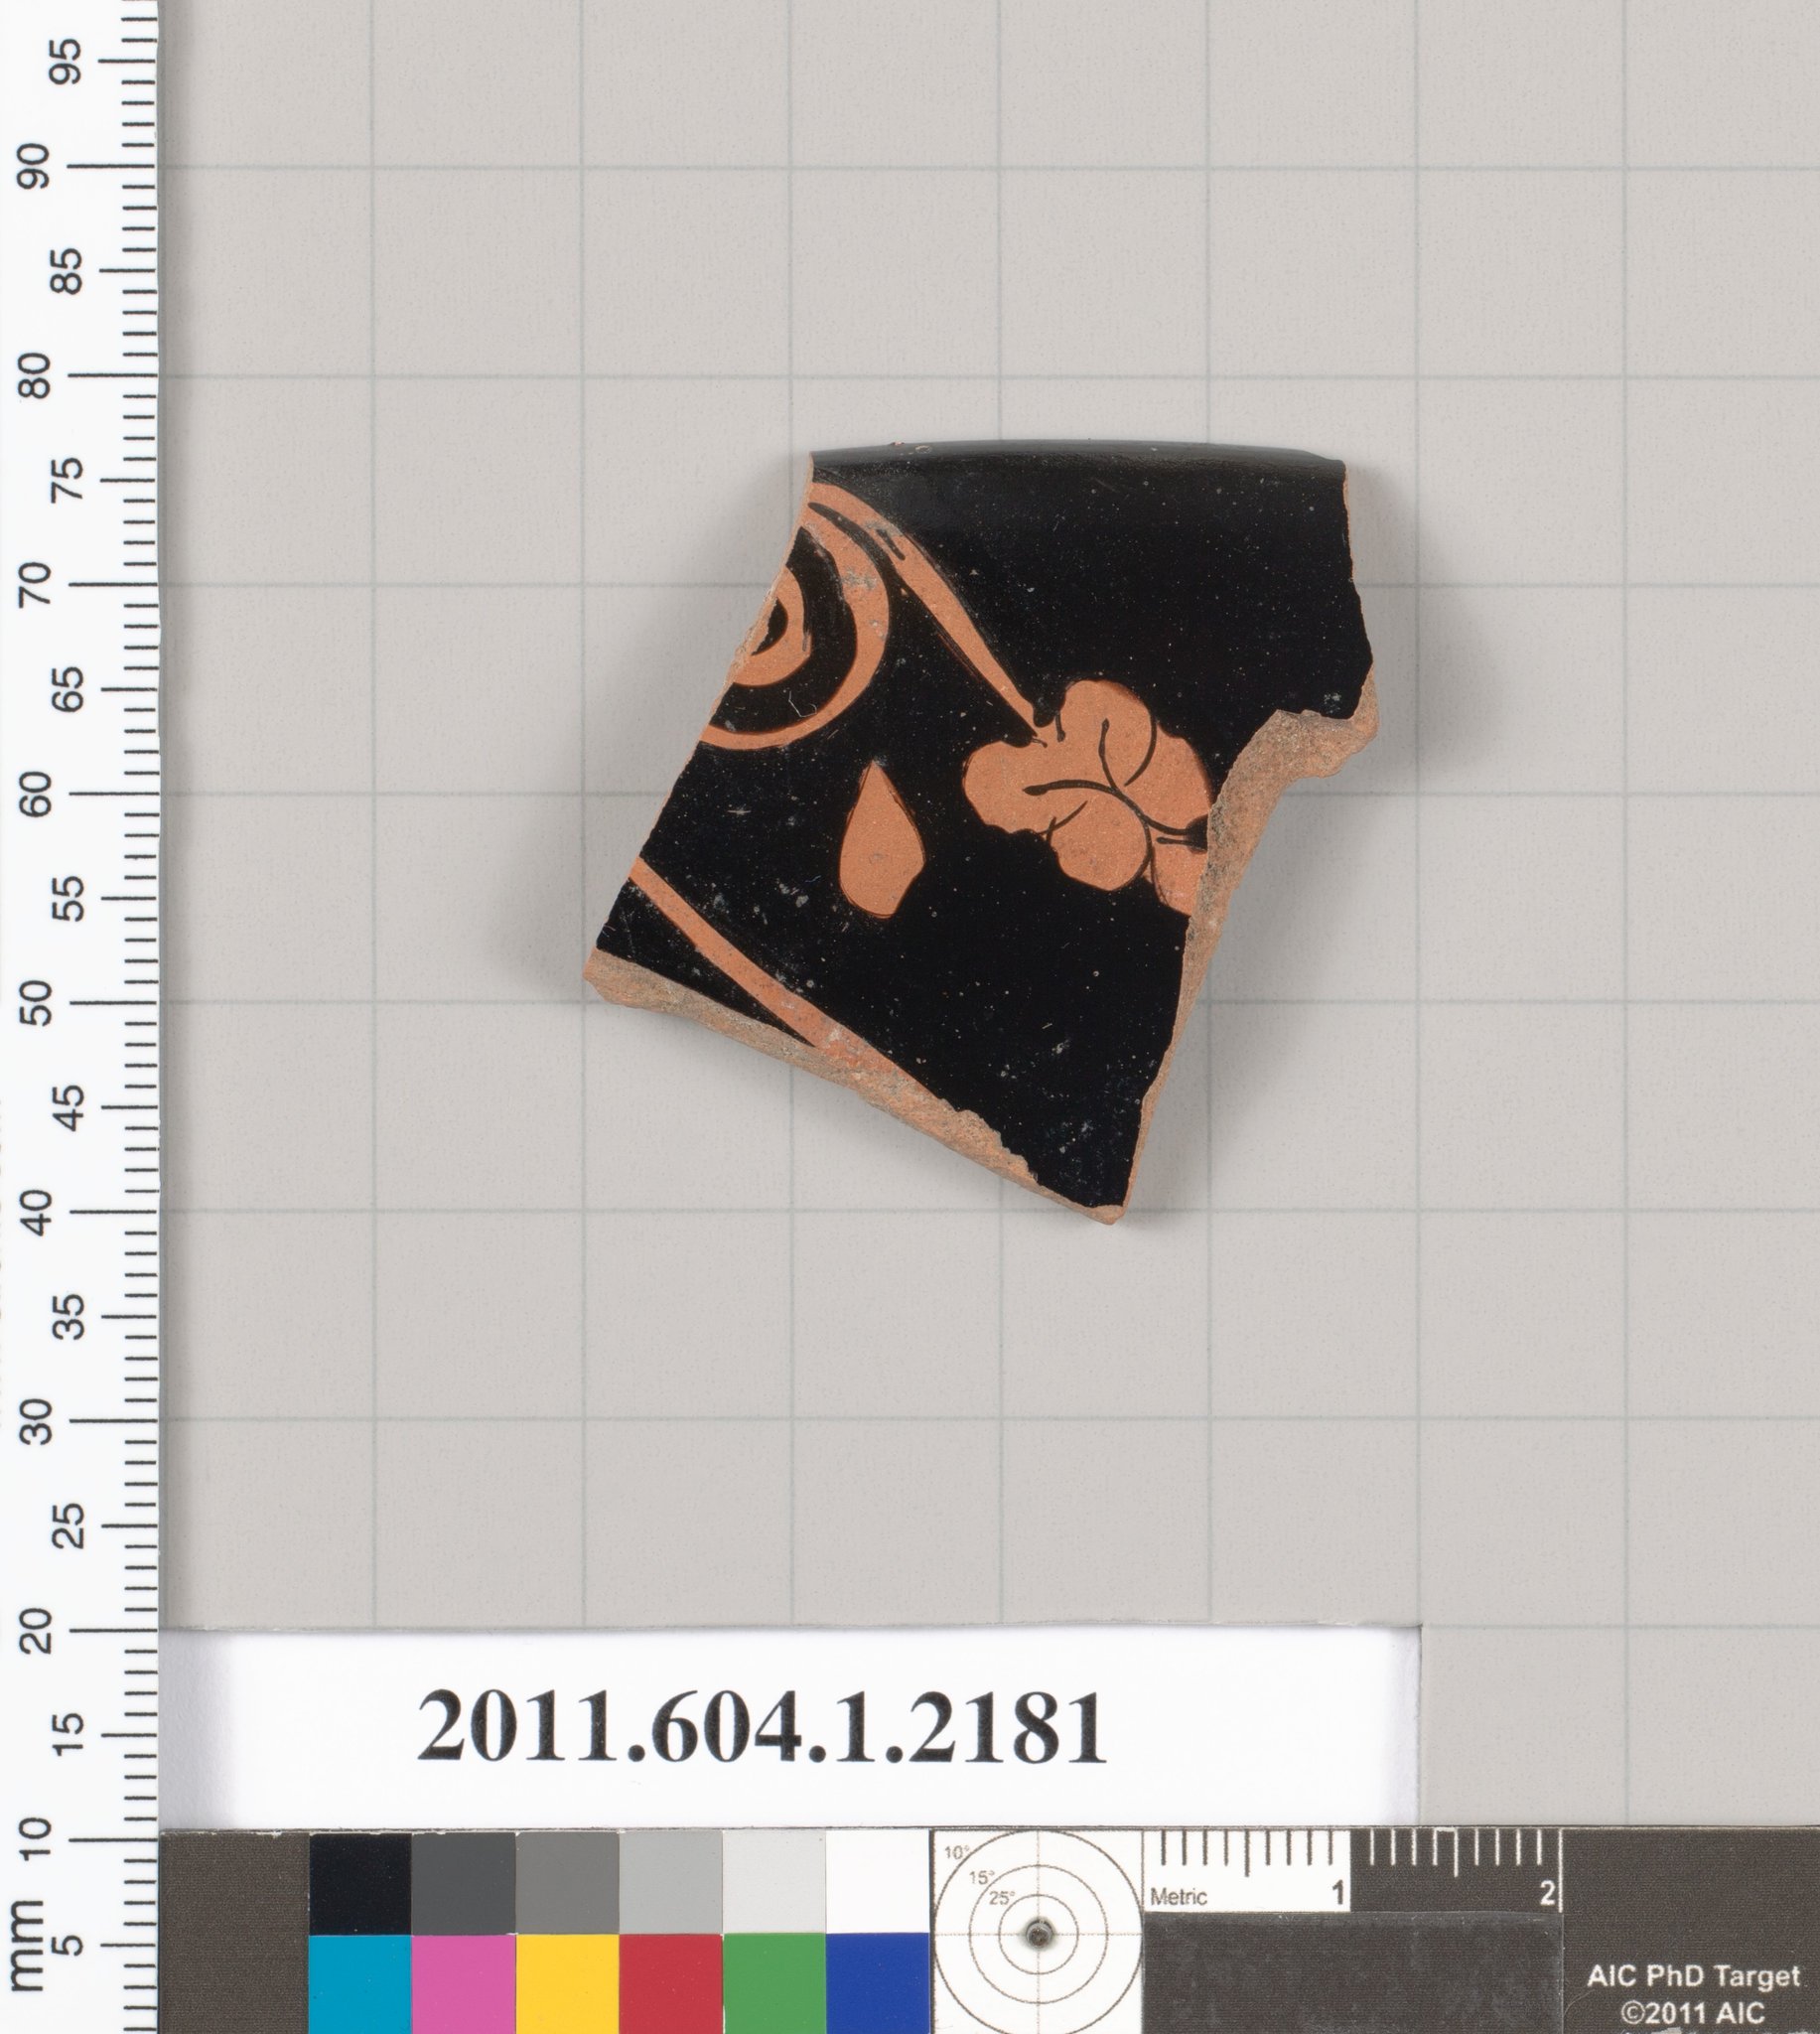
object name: kylix fragment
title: Terracotta rim fragment of a kylix (drinking cup)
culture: greek, attic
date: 475-451 BCE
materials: terracotta